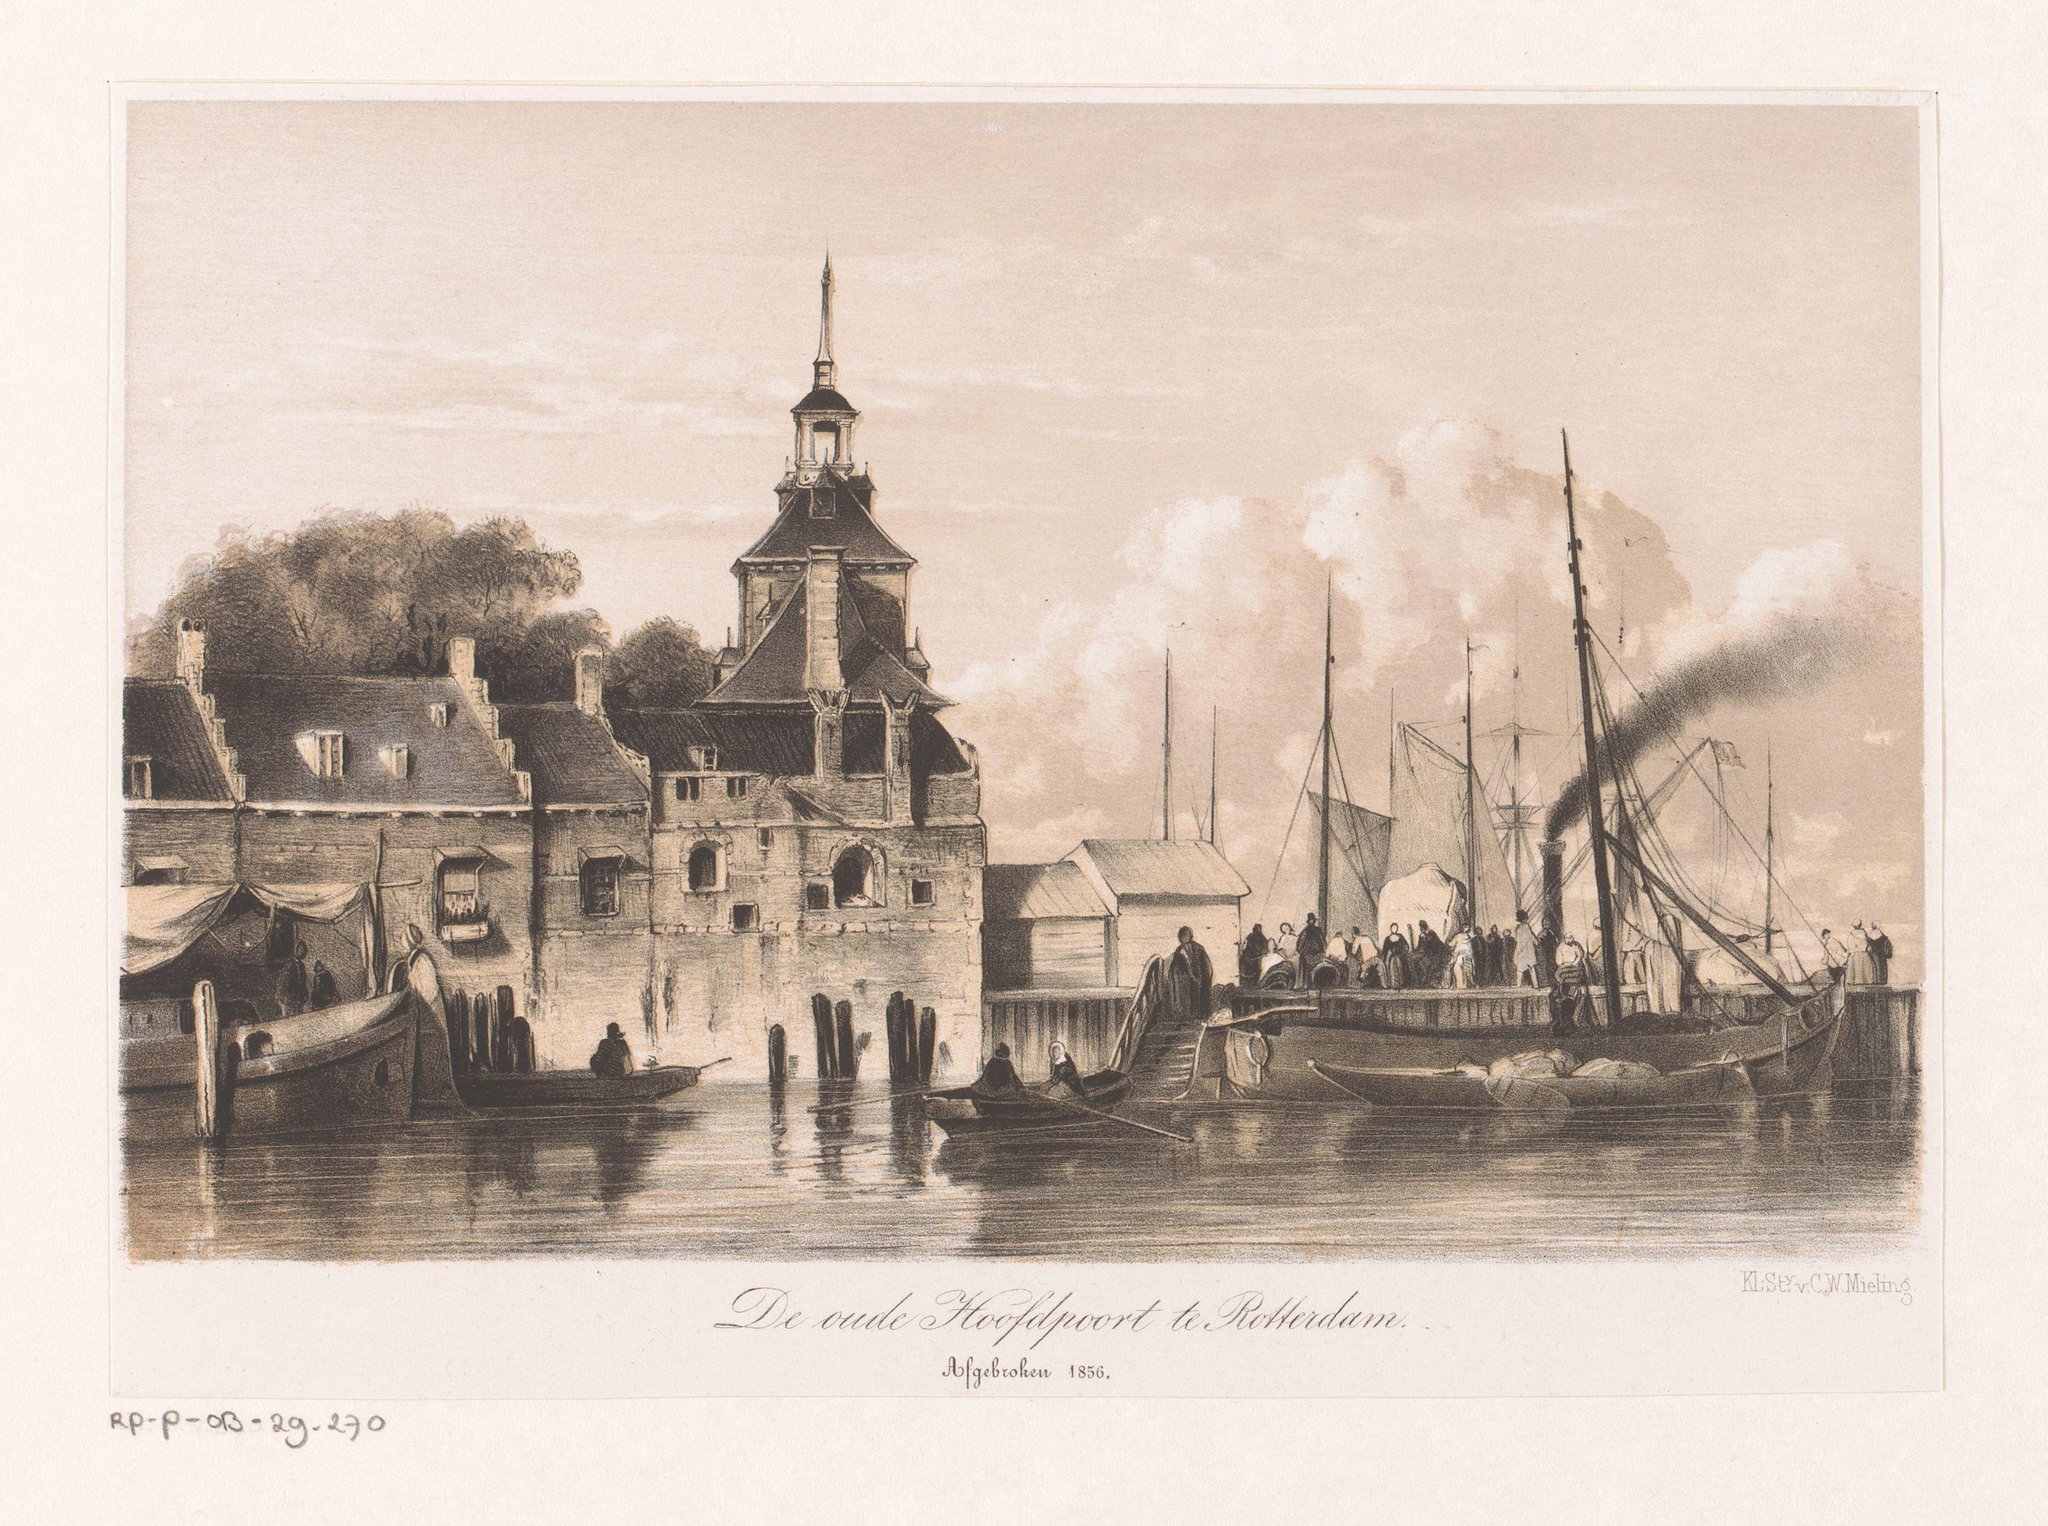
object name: print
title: Gezicht op de Ooster Oude Hoofdpoort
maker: Anonymous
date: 1863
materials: paper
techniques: tone lithography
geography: the hague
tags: city-gate, steamship, motorship, rotterdam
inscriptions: collector's mark: Lugt 2228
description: Op de kade staat een groep mensen naar een stoomboot te kijken.